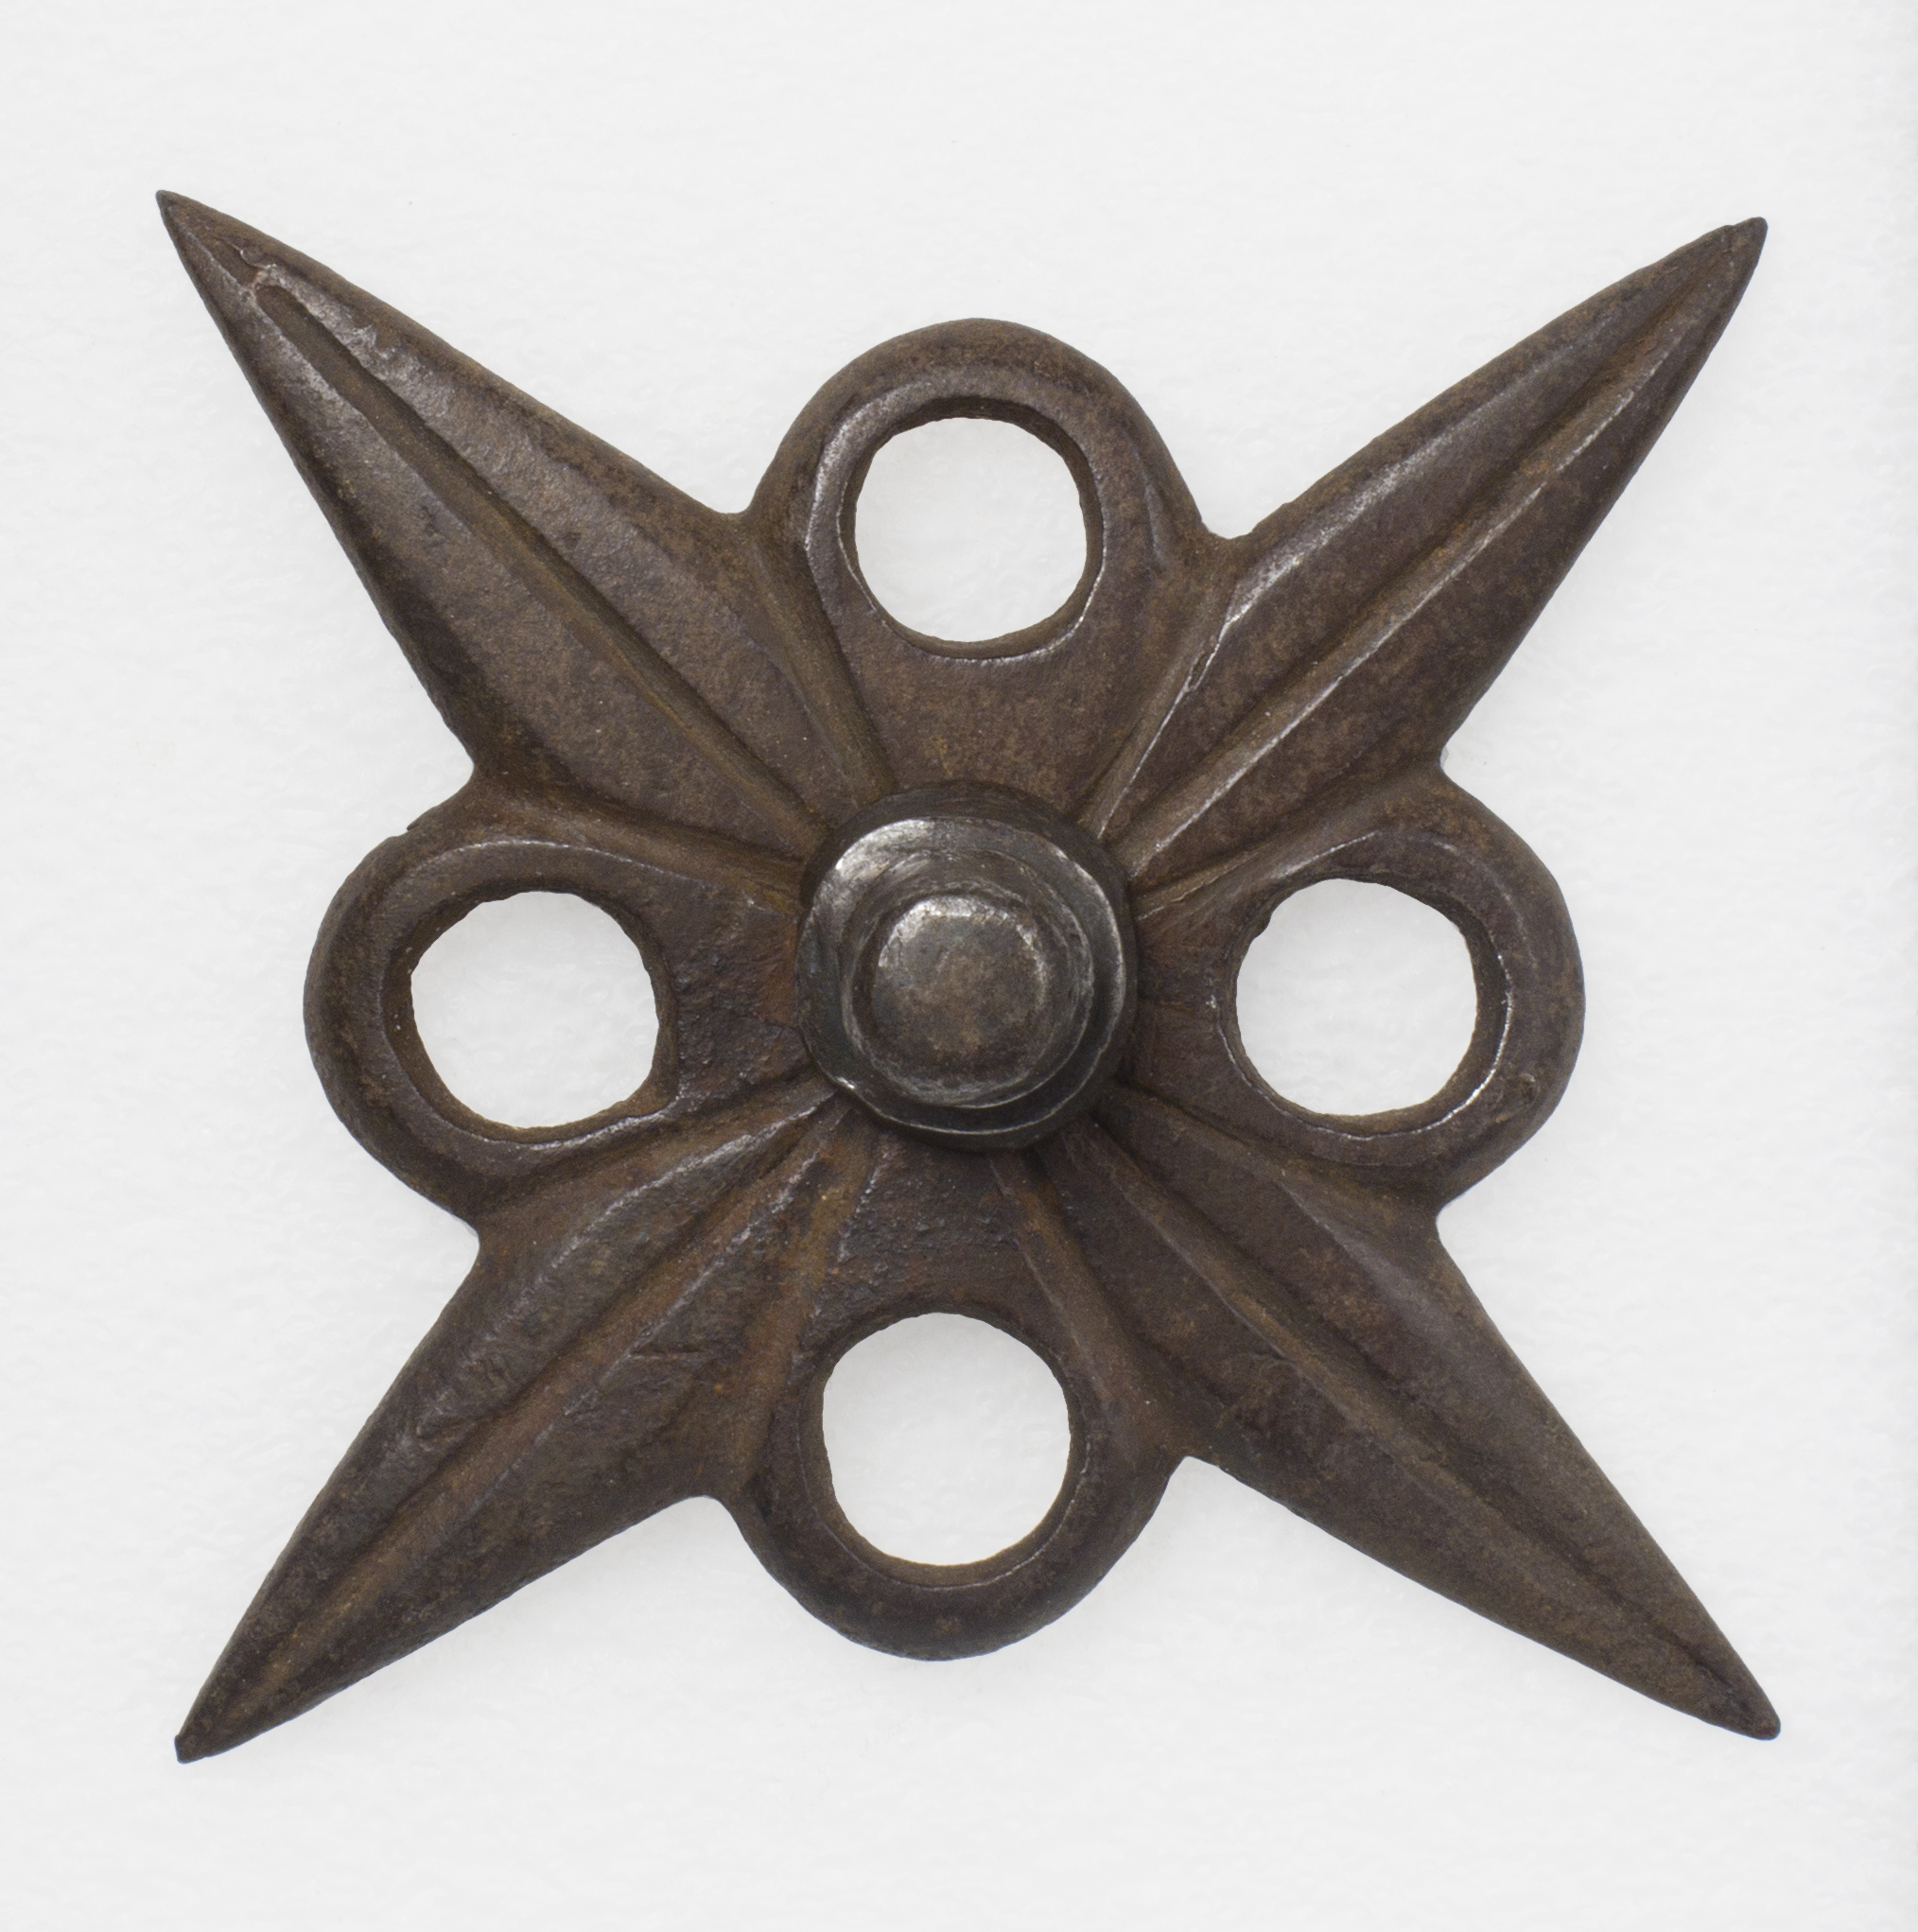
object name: plate and nail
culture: european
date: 1401-1600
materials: iron